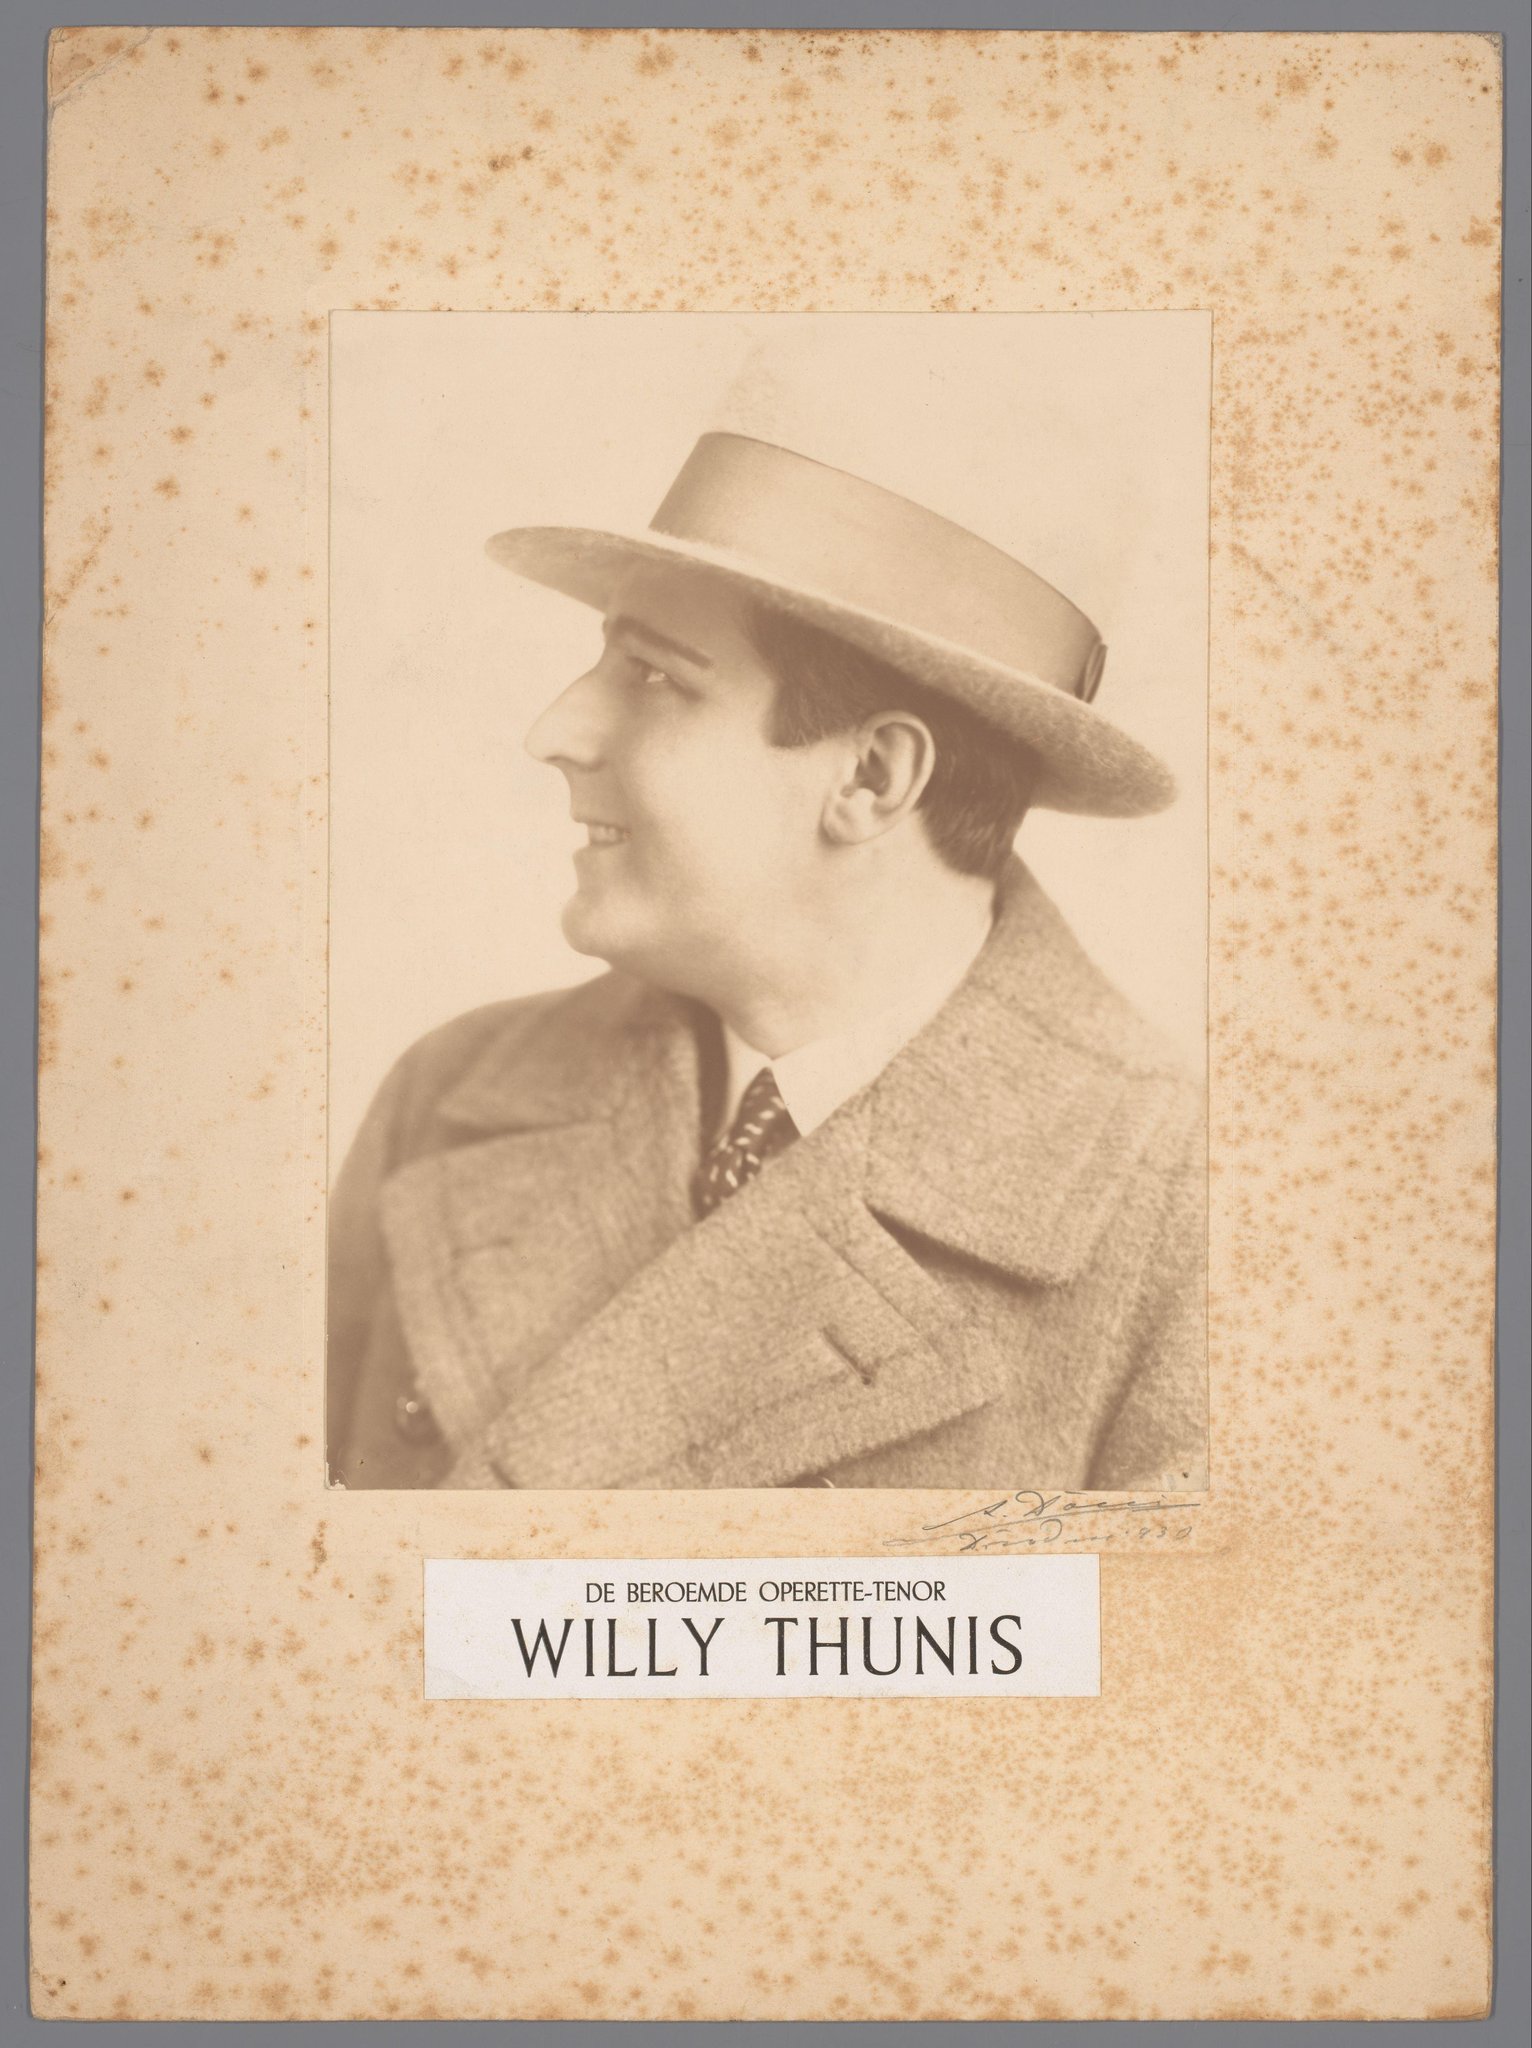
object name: photograph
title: De beroemde operette-tenor Willy Thunis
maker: Anonymous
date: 1930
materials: paper, cardboard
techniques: gelatin silver print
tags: portrait of opera-singer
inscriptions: inscription: ‘foto afkomstig legaat fam. [...] A'dam 1961/ 9732/ 7x10’